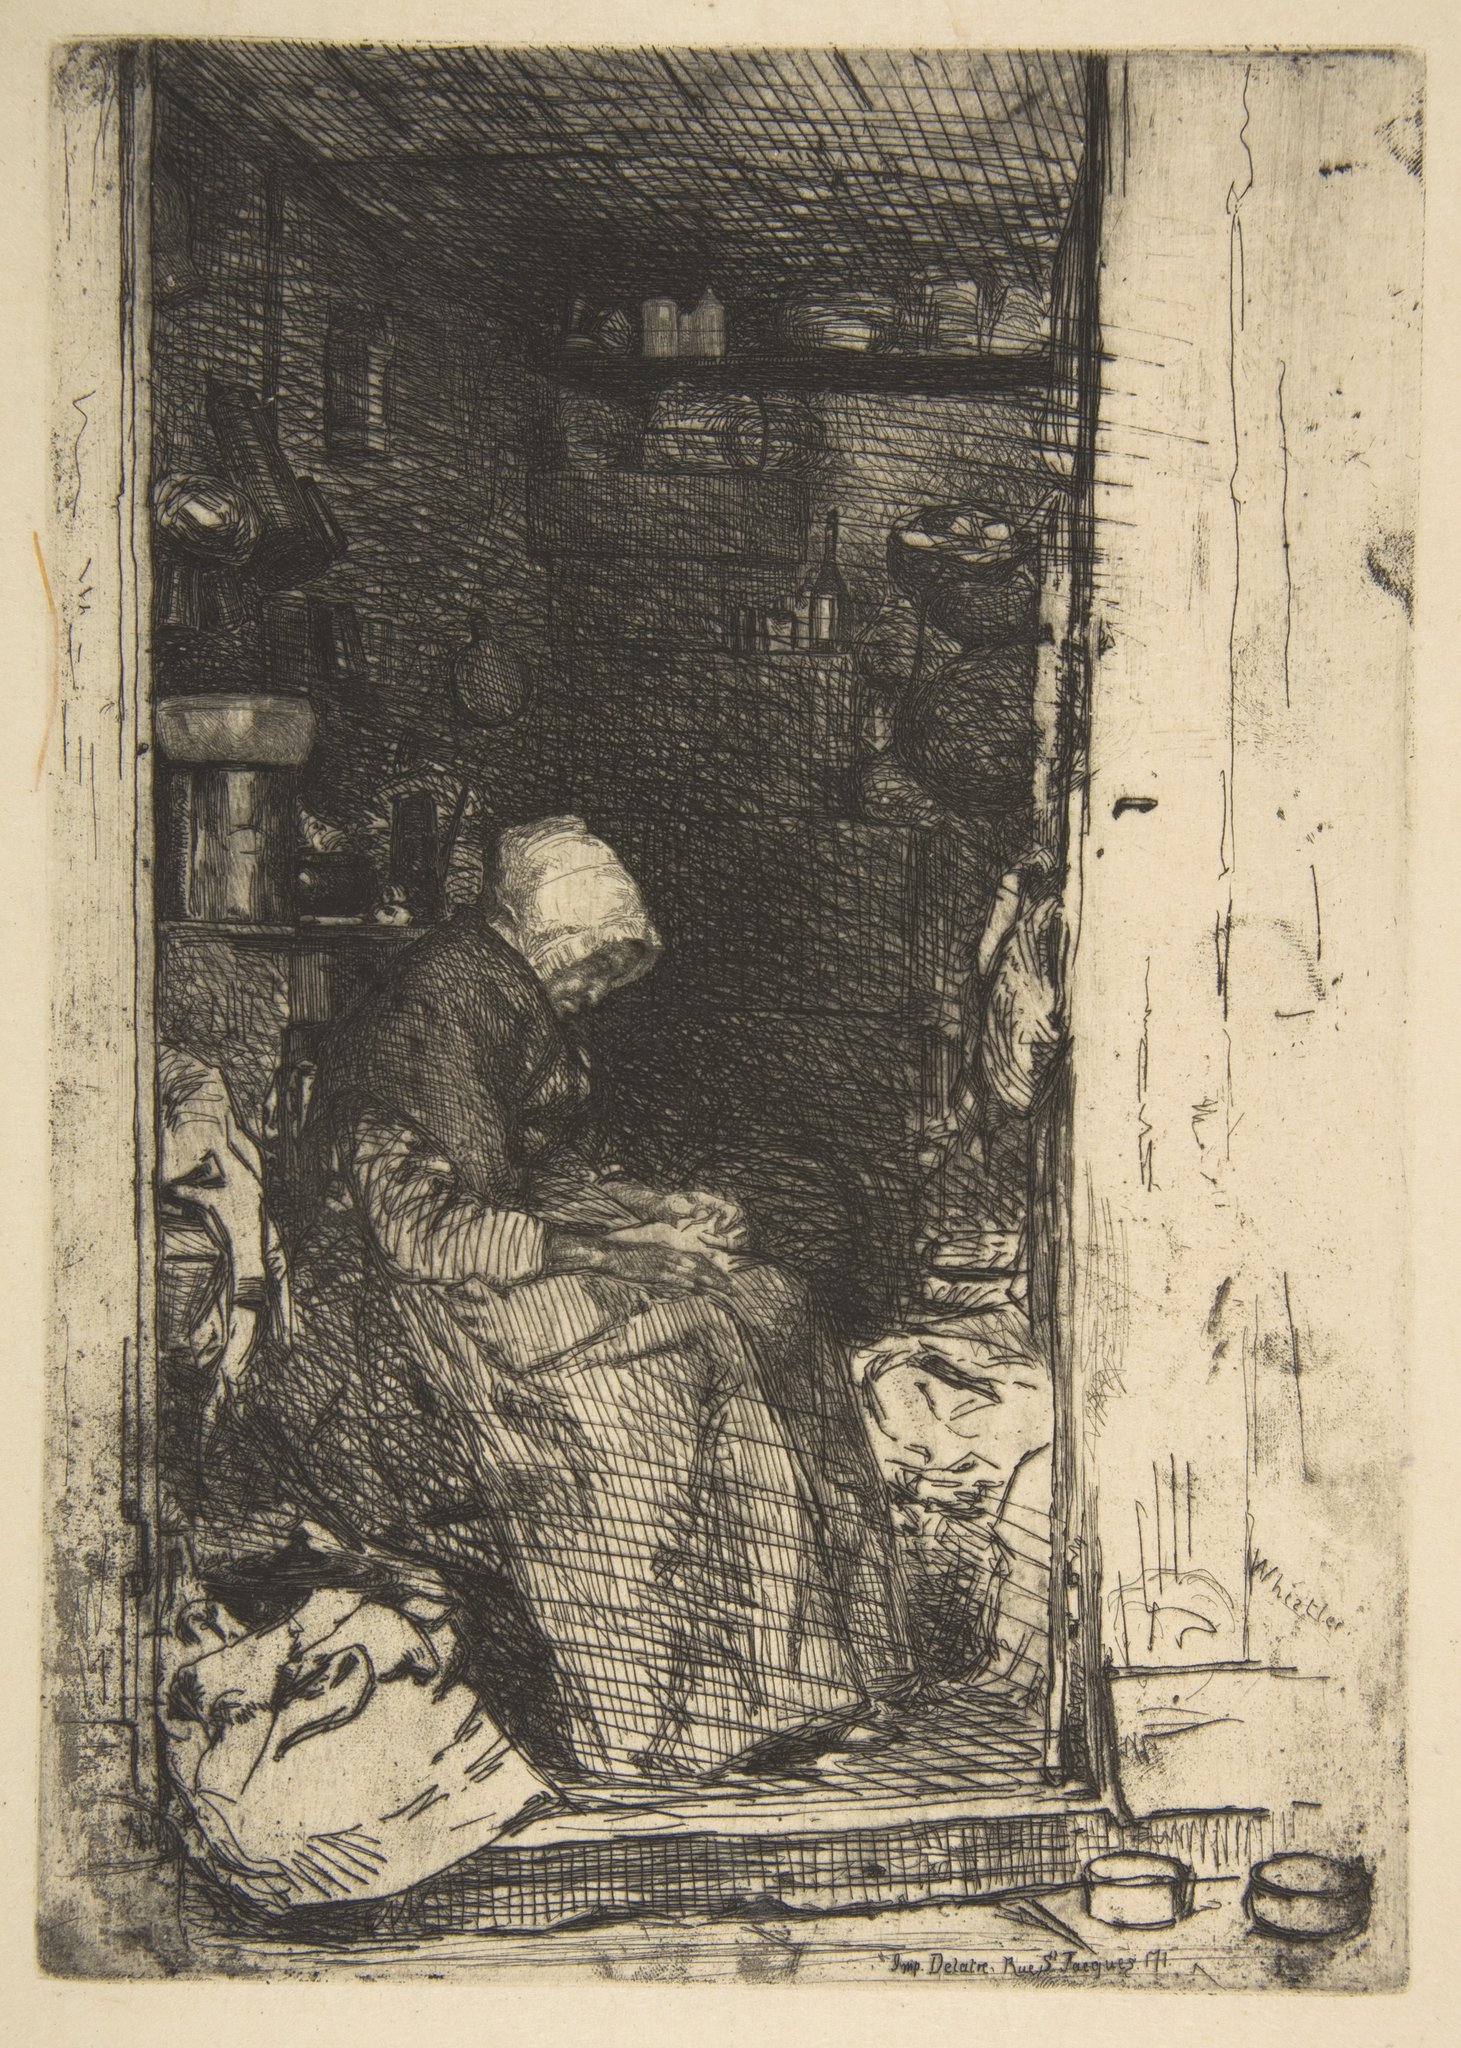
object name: print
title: La Vieille aux loques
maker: james mcneill whistler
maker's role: artist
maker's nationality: american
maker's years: 1834-1903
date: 1858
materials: ink, paper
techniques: drypoint, etching, printing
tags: women,working